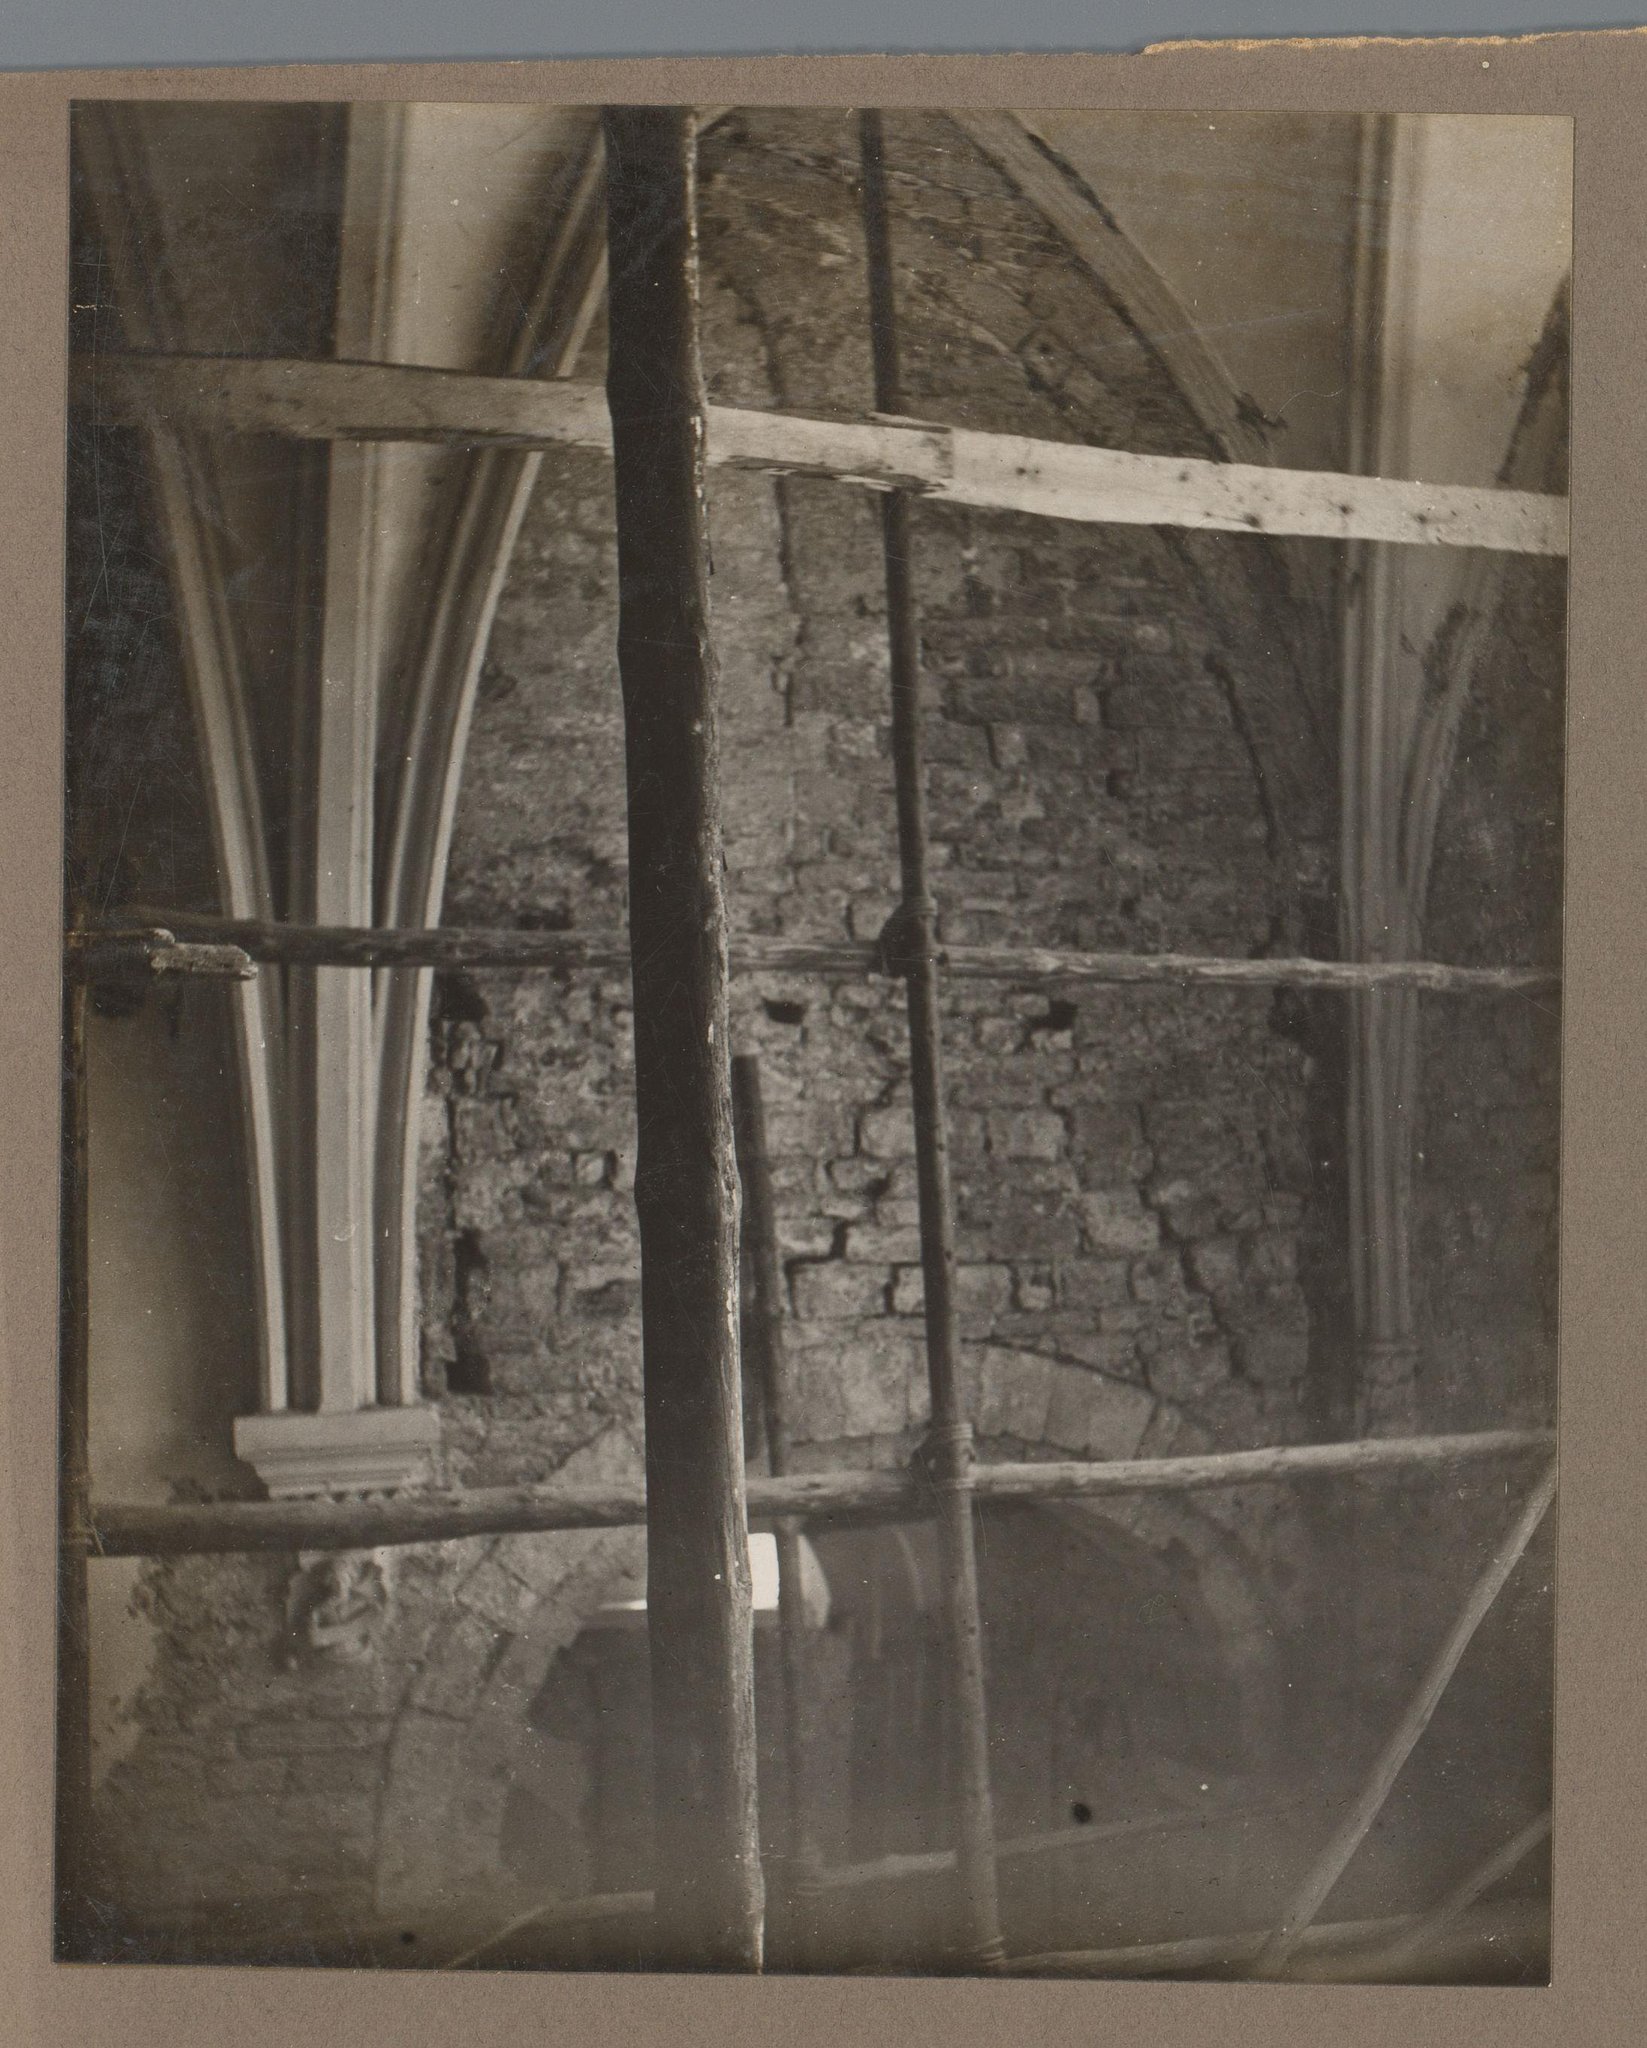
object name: photograph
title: Gestut gewelf staat op instorten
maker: Anonymous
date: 1880-1920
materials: photographic support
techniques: gelatin silver print